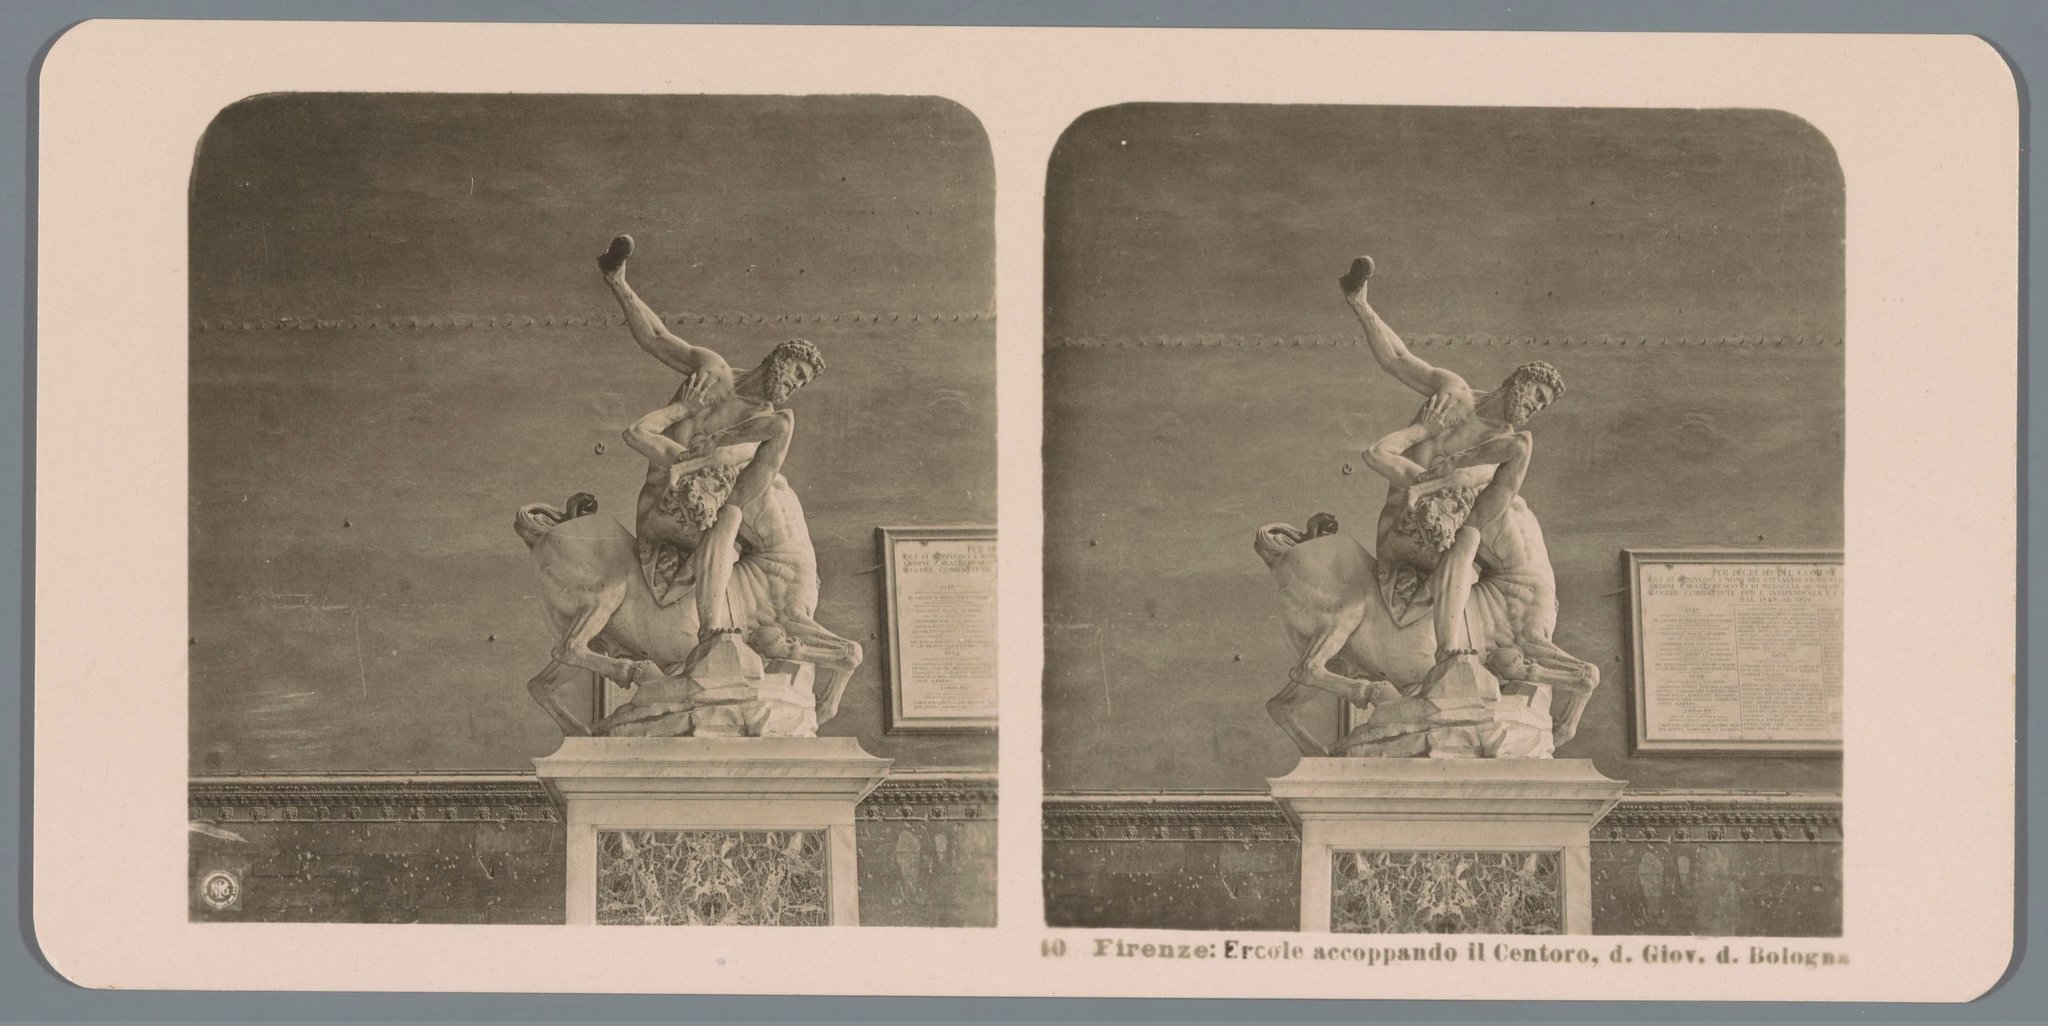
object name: stereograph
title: Firenze: Ercole accoppando il Centoro, d. Giov. d. Bologna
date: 1900-1910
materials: cardboard, photographic support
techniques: gelatin silver print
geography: loggia dei lanzi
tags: sculpture, hercules' fight with the centaurs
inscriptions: inscription: ‘NPG’, number: ‘40’